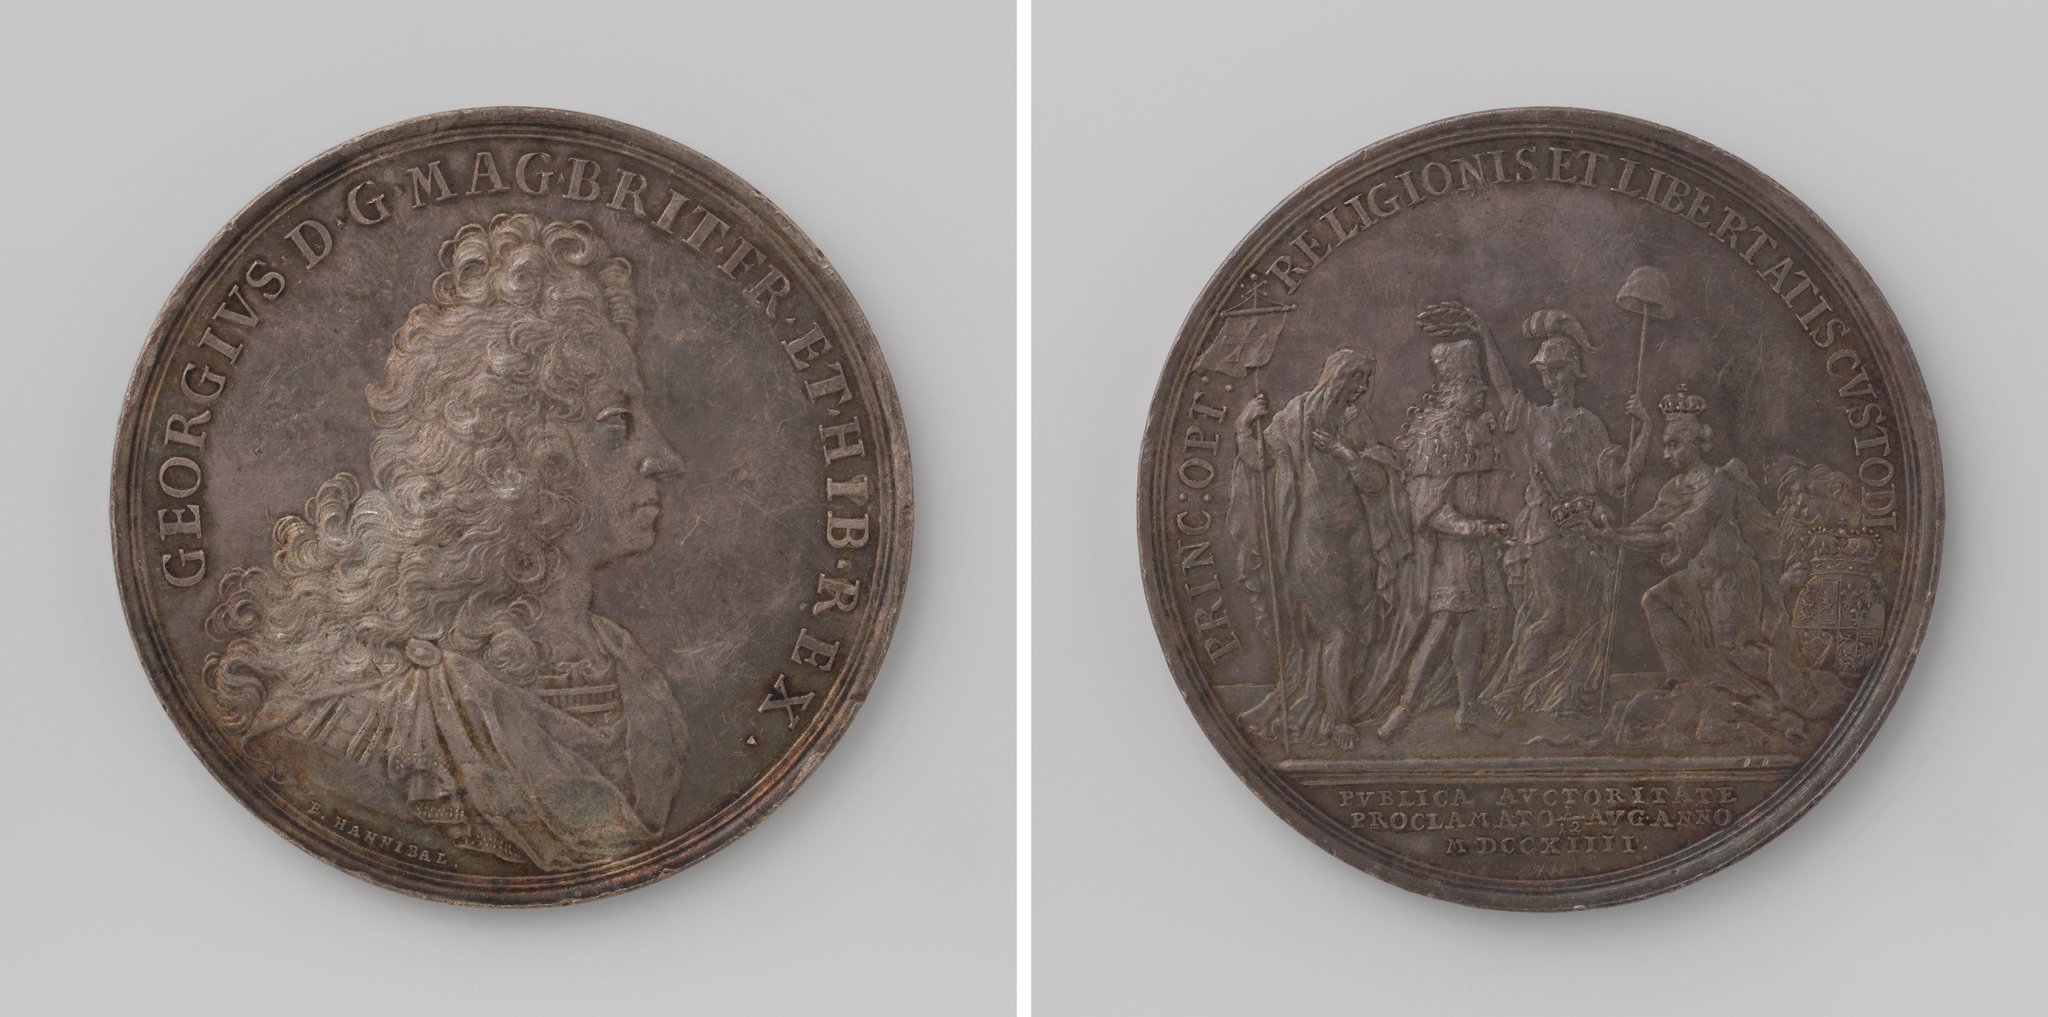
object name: history medal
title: George Lodewijk, keurvorst van Hannover uitgeroepen tot koning van Groot-Britannie en Ierland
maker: ehrenreich hannibal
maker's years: 1678-1741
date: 1714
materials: silver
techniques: striking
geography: hannover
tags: george i (koning van groot-brittannië en ierland)